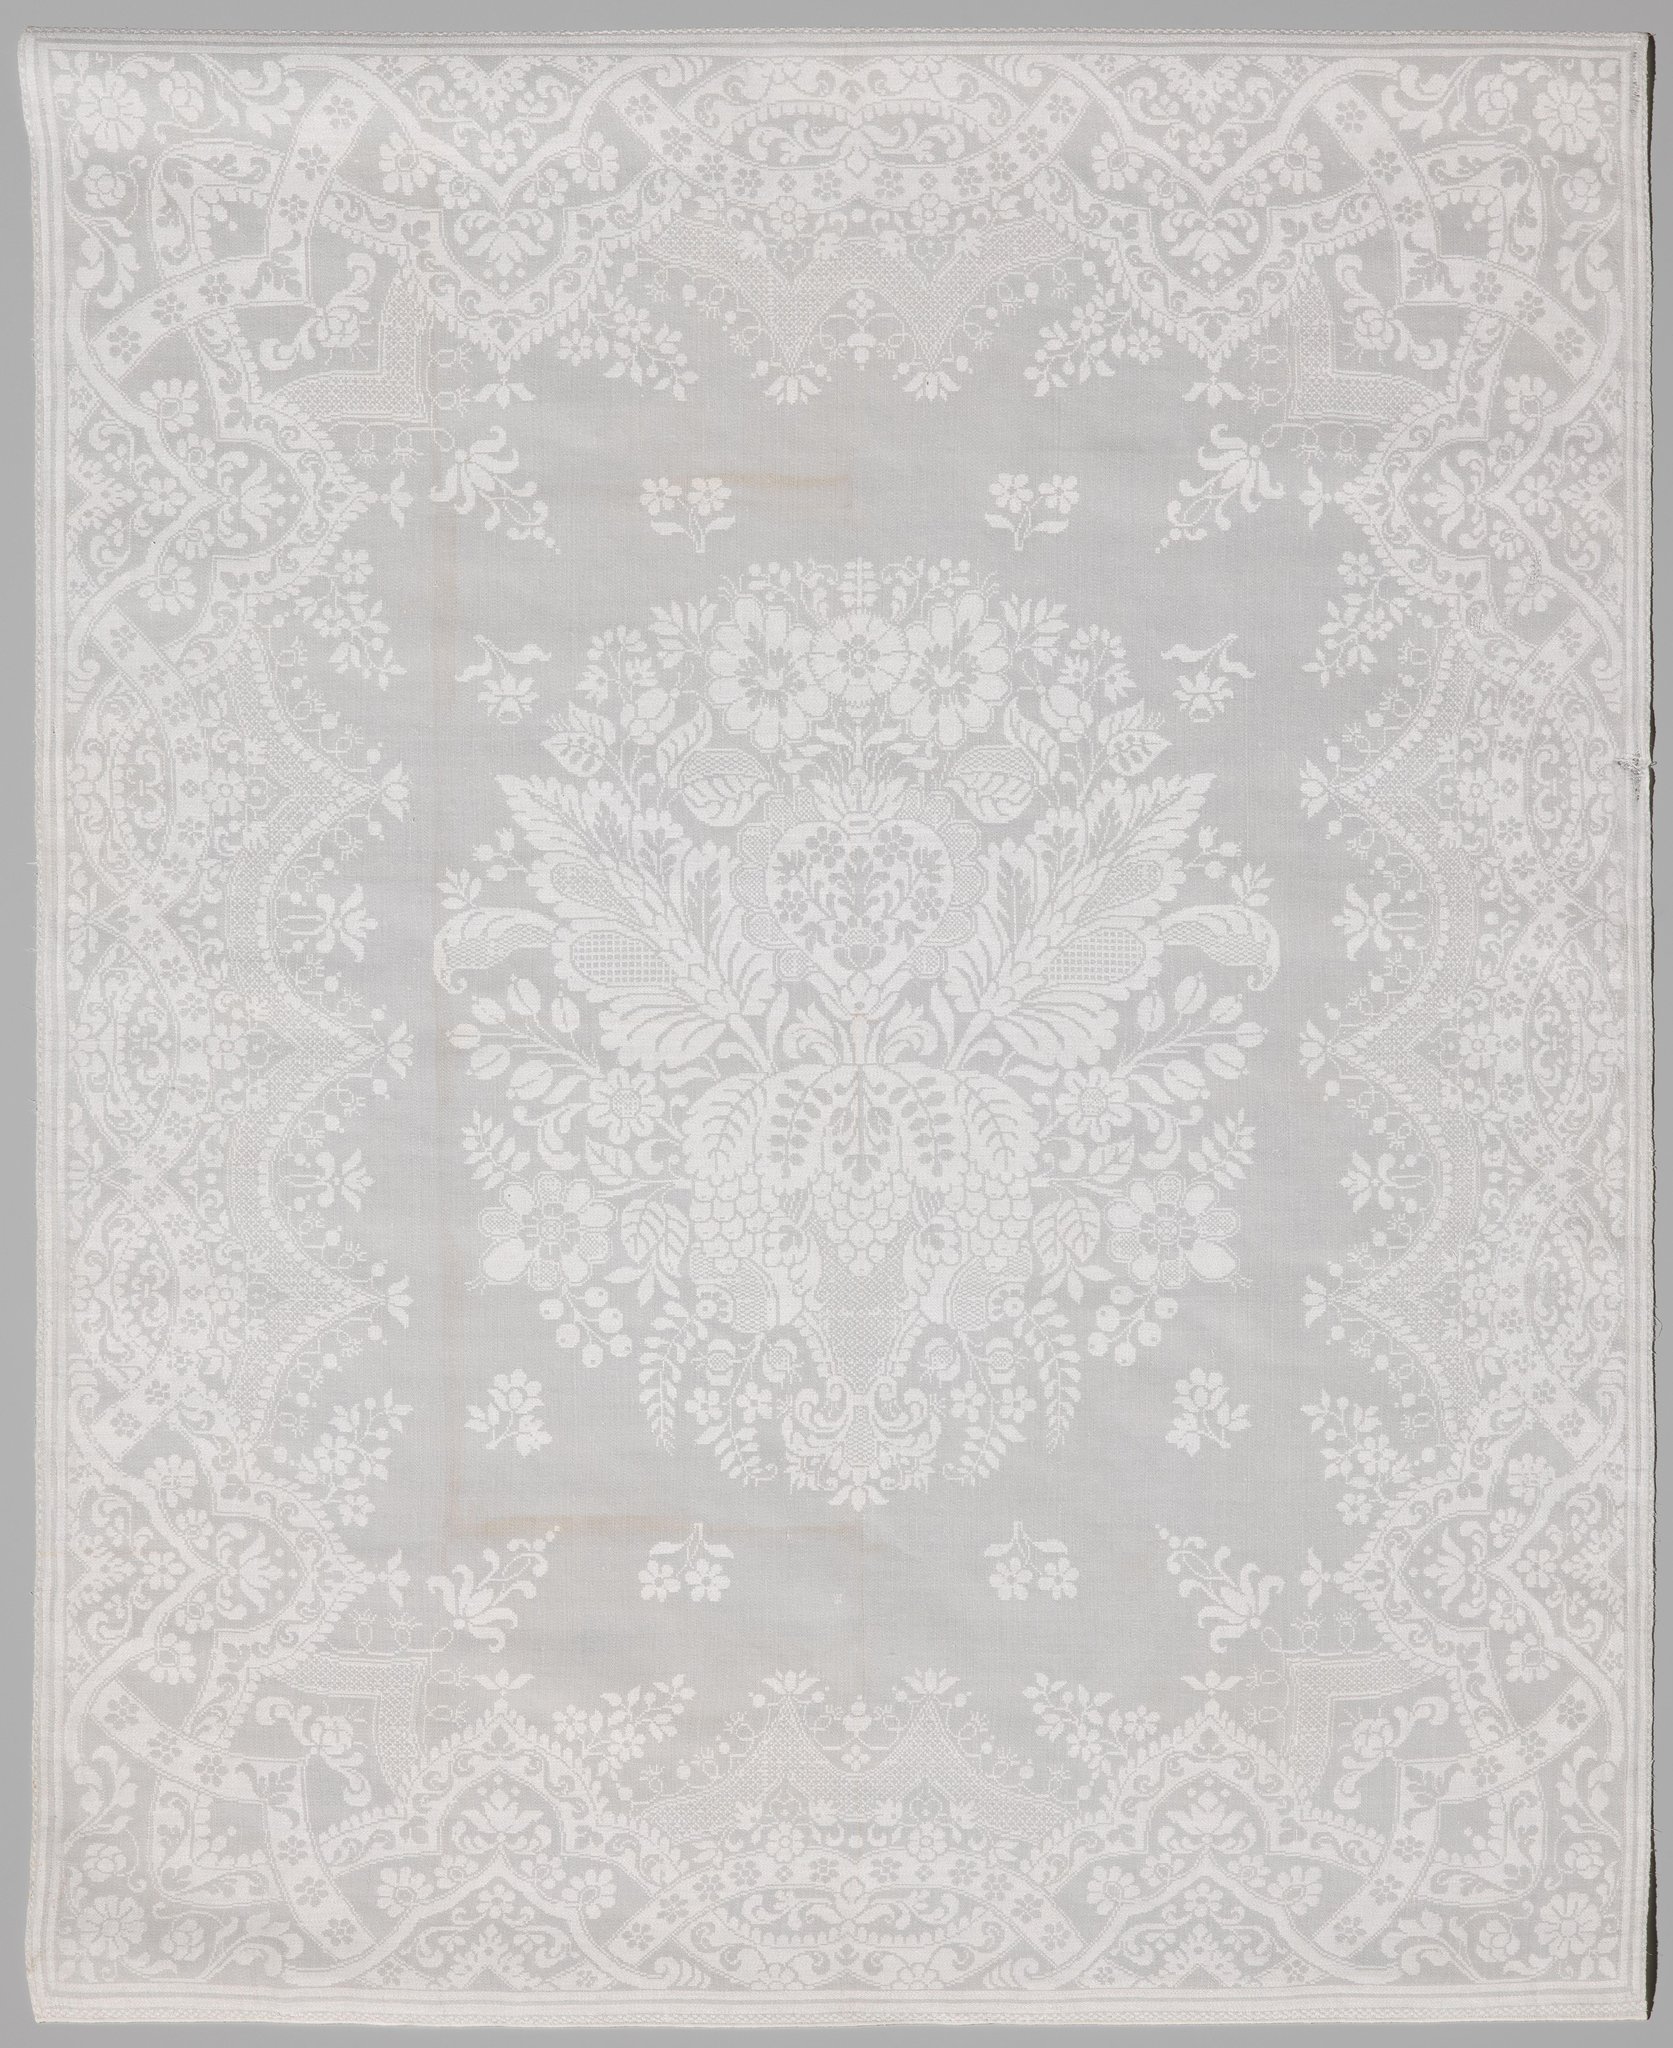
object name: napkin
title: Bloemornamenten en bandwerk. Merk: SAL 18 WH 200nl.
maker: Anonymous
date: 1800-1899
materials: linen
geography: netherlands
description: Servet van wit linnen met een patroon van bloemornamenten en bandwerk, merk SAL en 18 WH 2oonl